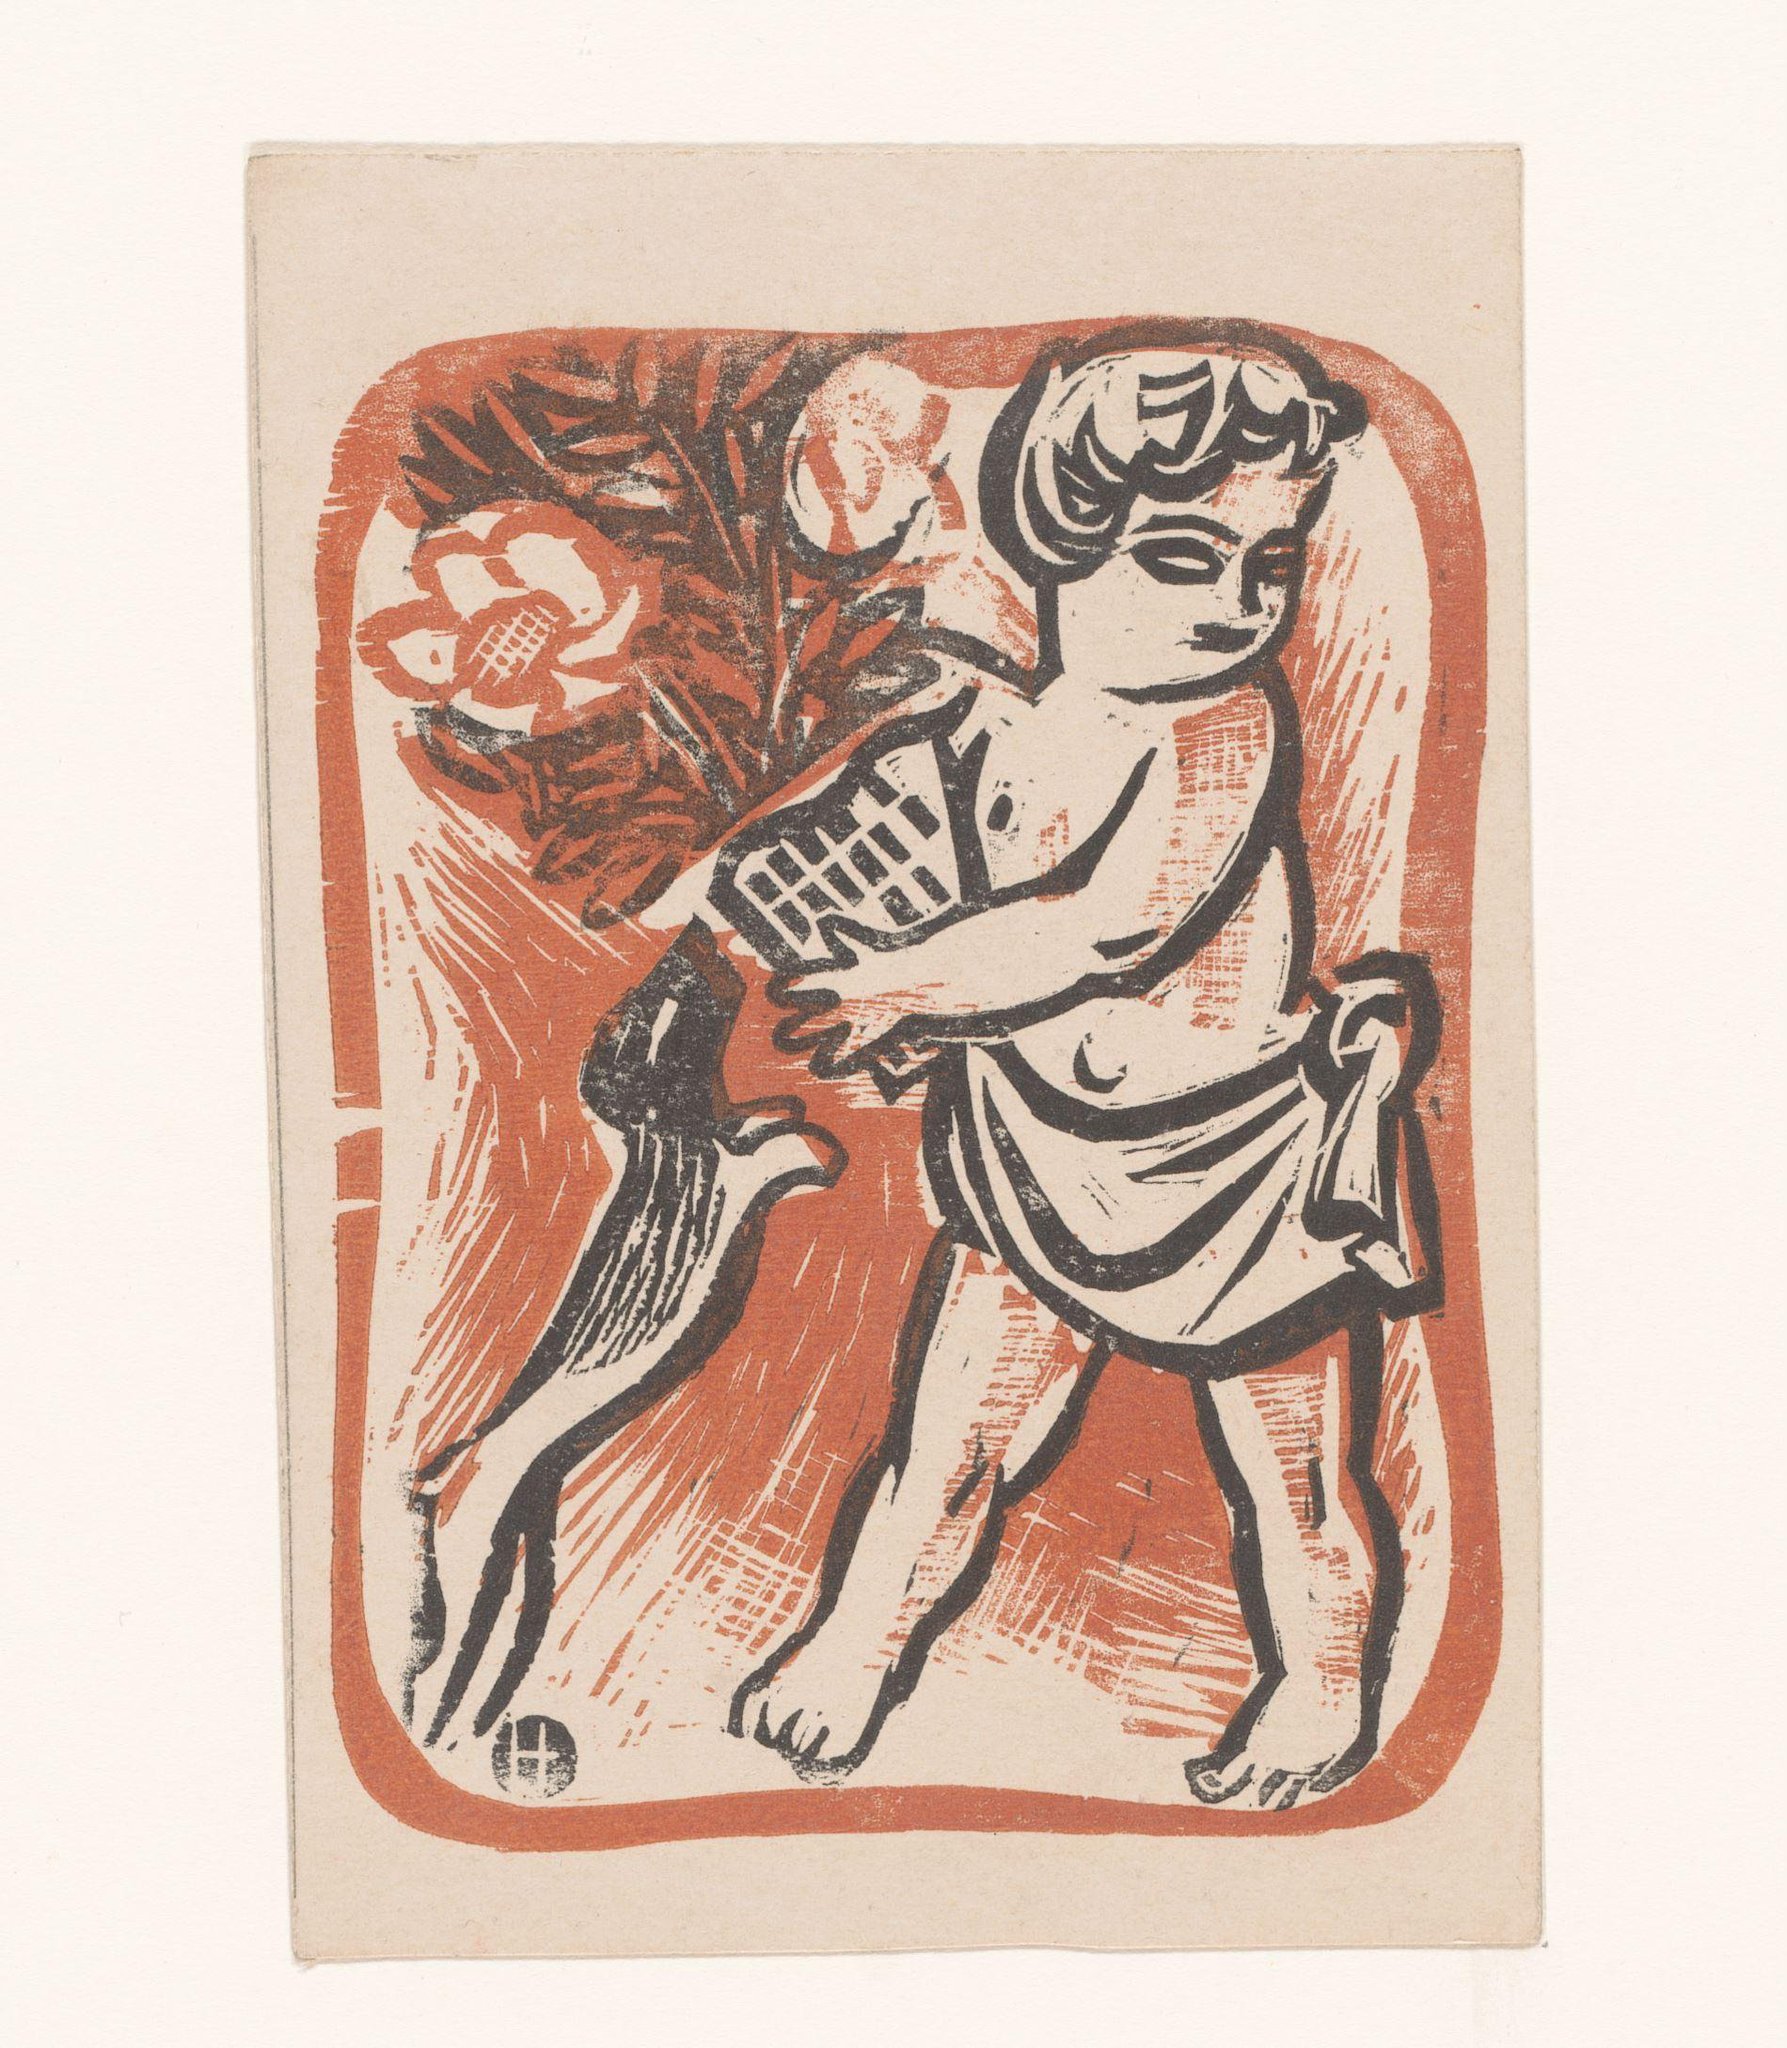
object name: print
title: Kind met bloemen en hond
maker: ad. hoffmann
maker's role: print maker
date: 1900-1947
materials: paper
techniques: woodcut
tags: boy (child between toddler and youth), dog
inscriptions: collector's mark: Lugt 2228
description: Geboorte- en sterfdatum van de prentmaker zijn onbekend. Daarom is voor de bepaling van de rechten van dit object gebruik gemaakt van de verwervingsdatum Rijksmuseum Amsterdam.